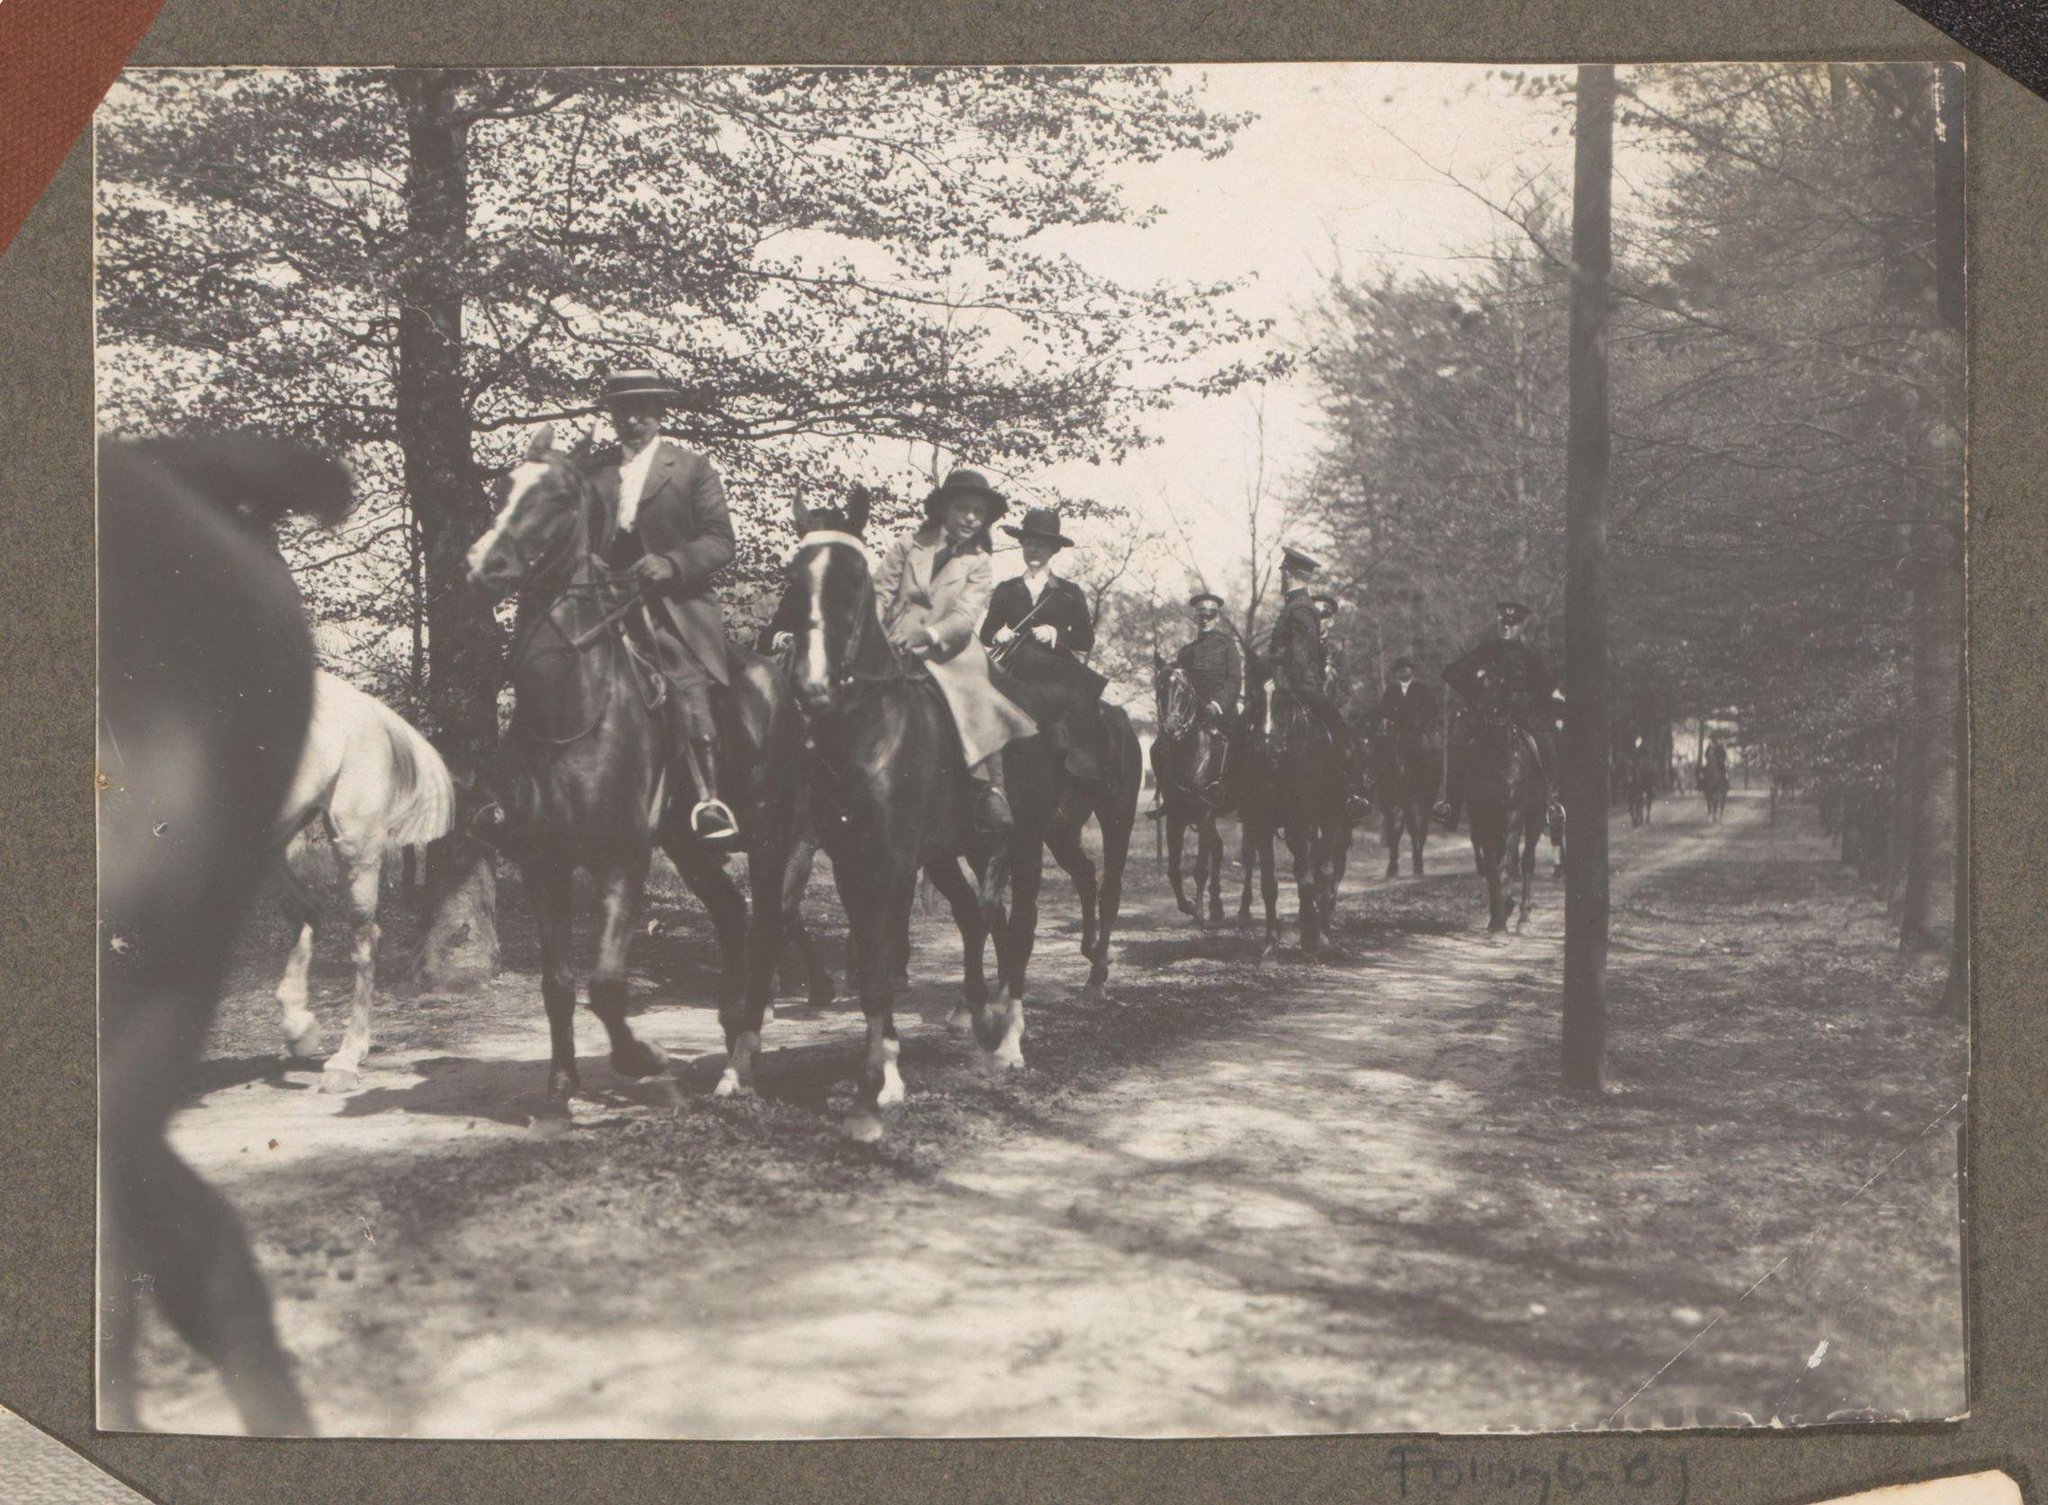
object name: photograph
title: Ruitertafereel op Koninklijke Houtvesterij Het Loo: ruiters op een laan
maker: Anonymous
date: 1900-1925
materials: photographic support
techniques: gelatin silver print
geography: het loo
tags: riding a horse, ass, or mule; rider, horseman, hunting, chase, hunting-ground, forest path or lane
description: Onderdeel van Fotoalbum van de heer Brams, opperhoutvester van koningin Wilhelmina op Koninklijke Houtvesterij Het Loo.